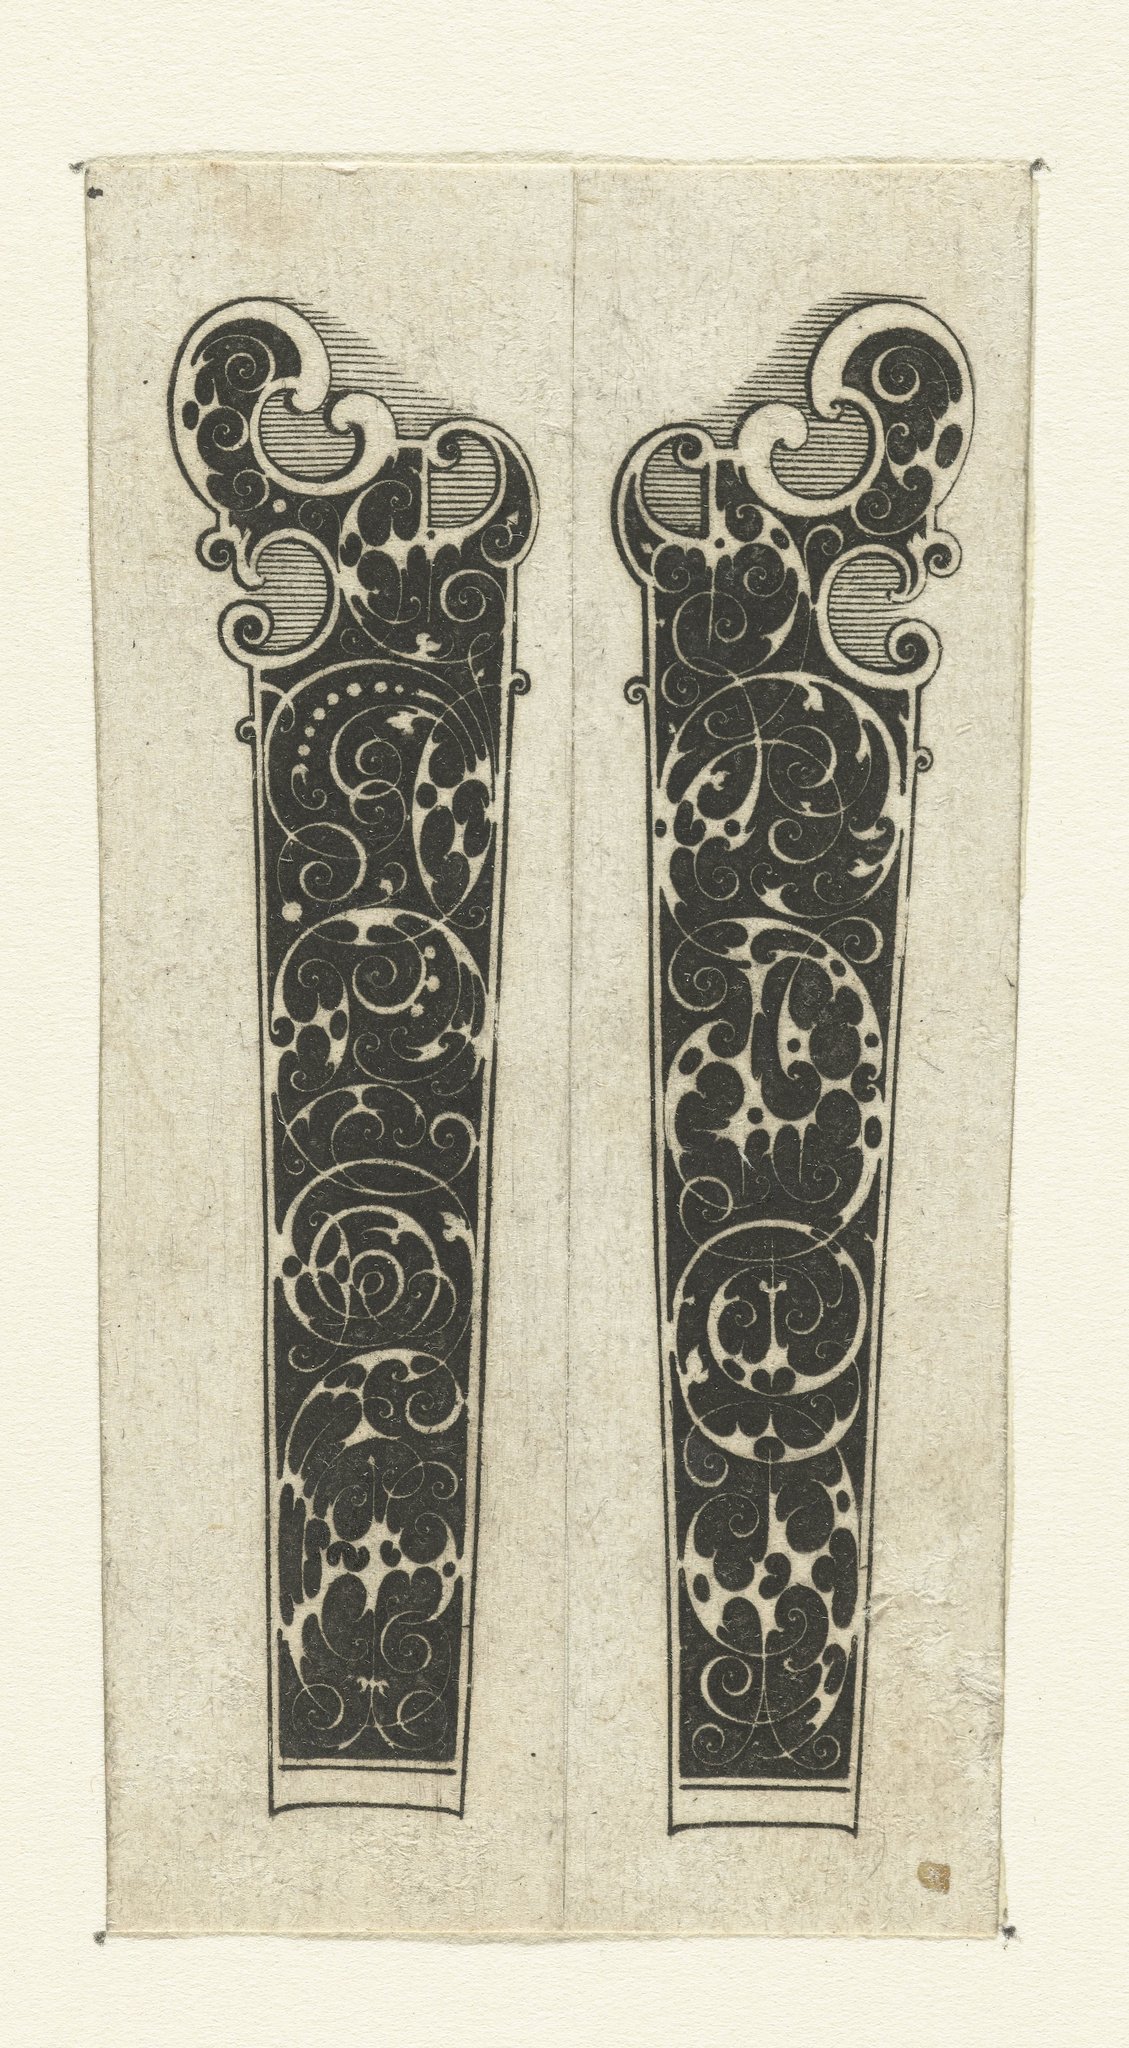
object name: print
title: Twee messenheften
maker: michiel le blon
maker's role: print maker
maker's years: 1587-1656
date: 1597-1625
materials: paper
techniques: etching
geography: amsterdam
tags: table-knife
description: Op elk blad uit deze serie staan twee messenheften naast elkaar afgebeeld, gedecoreerd met Schweifwerk en gestileerde ranken in wit op een zwarte ondergrond.